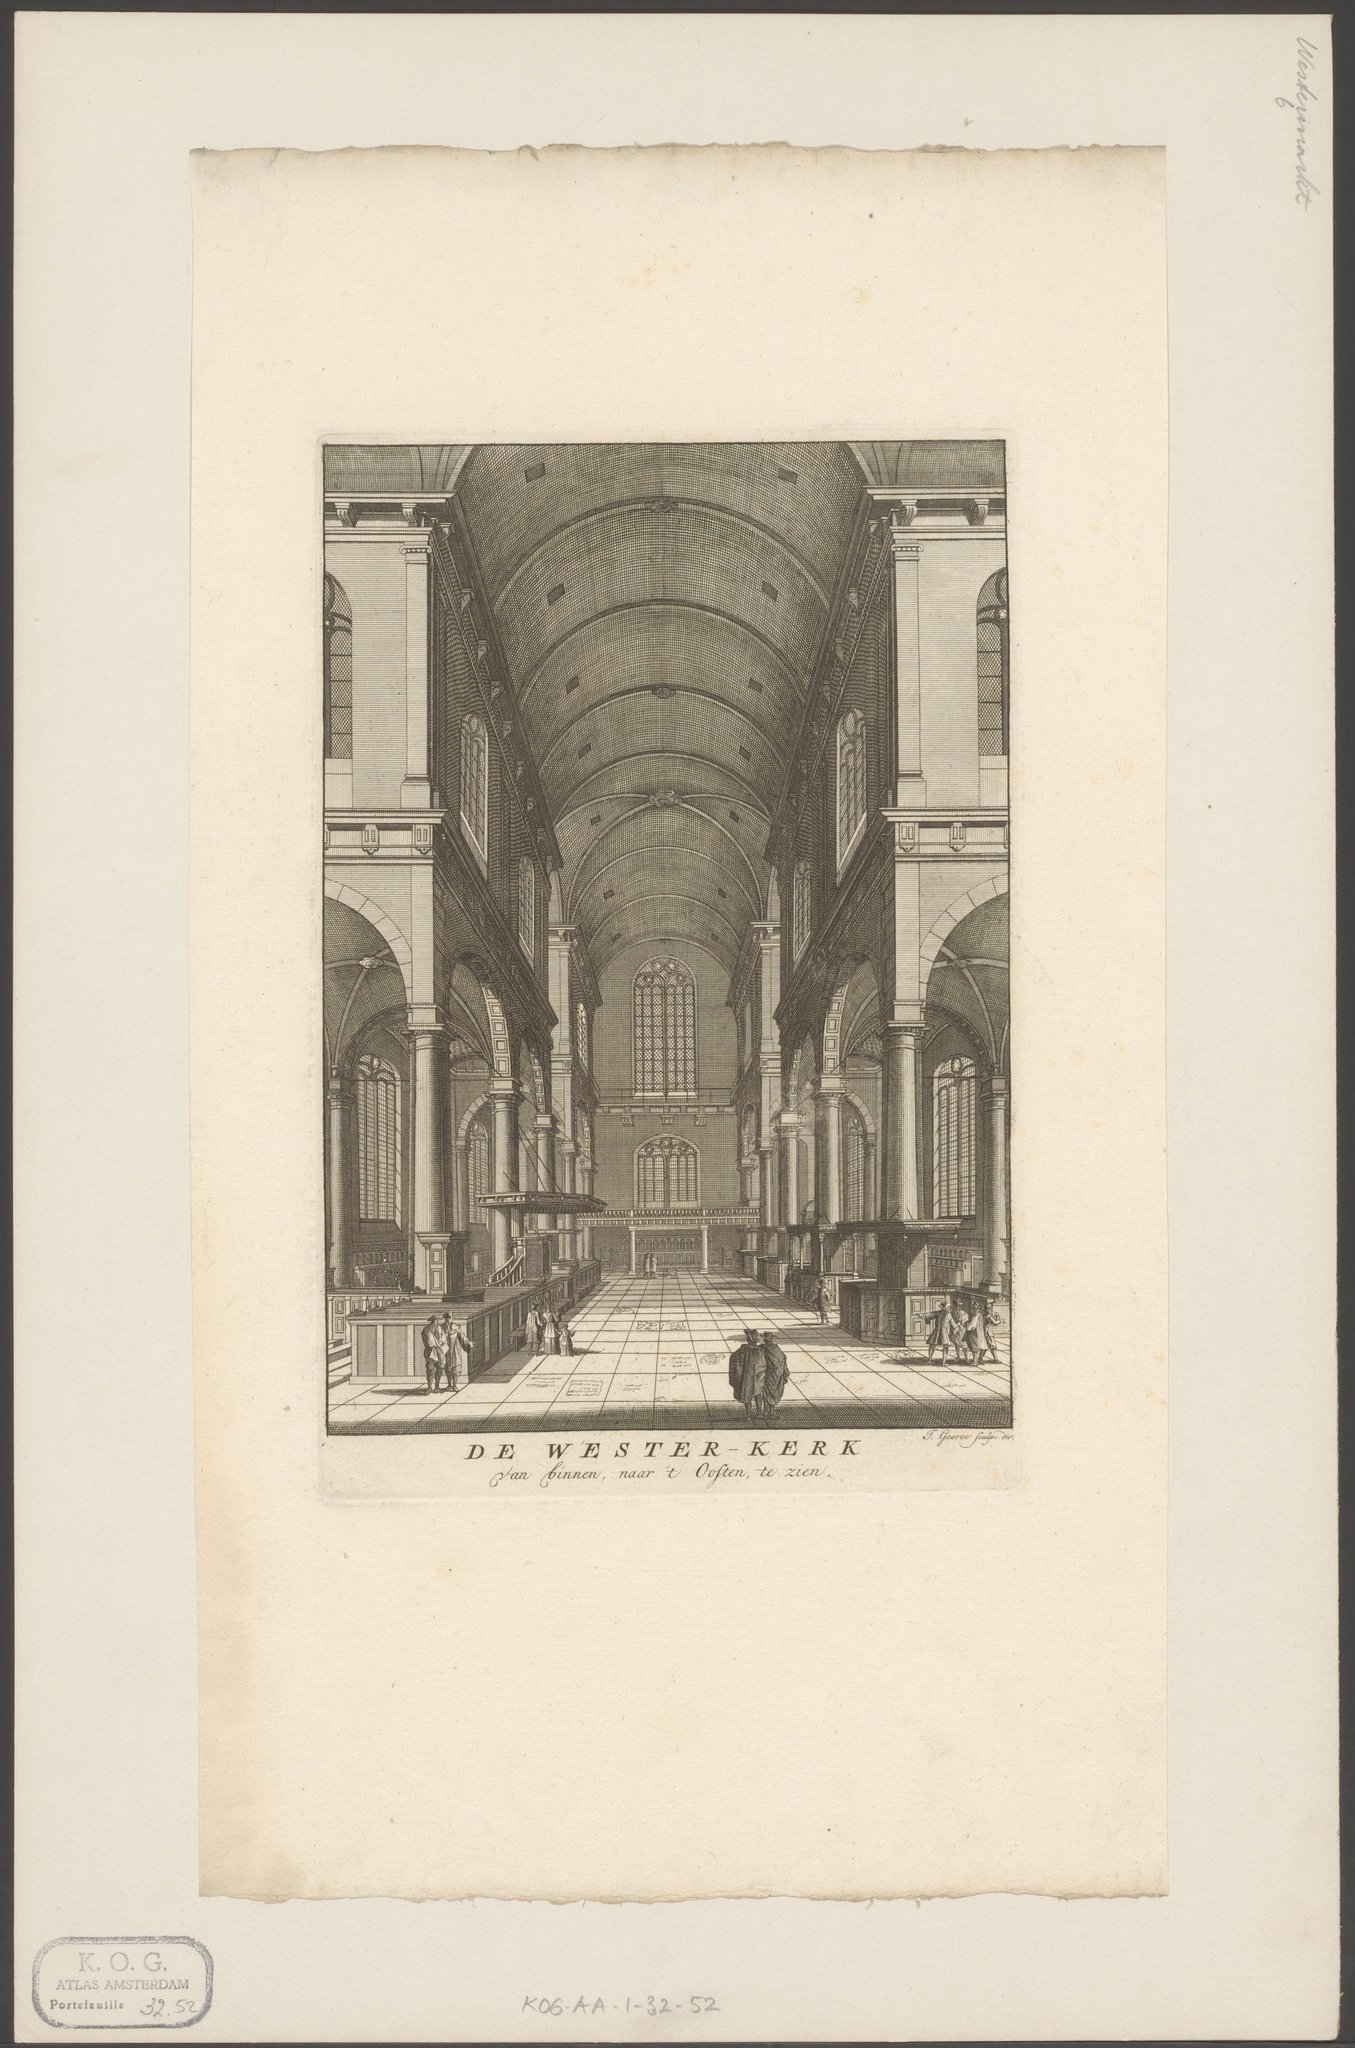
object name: book illustration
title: De Wester-kerk van binnen, naar 't Oosten, te zien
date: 1680-1731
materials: paper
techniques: engraving, etching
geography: amsterdam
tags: interior of church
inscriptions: collector's mark: ‘32.52’ Lugt 1641b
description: Prent mogelijk uit: Wagenaar, Jan. Amsterdam, in zyne opkomst, aanwas, geschiedenissen (...). Amsterdam: Isaak Tirion, 1765, dl. 2, tussen 132-133.